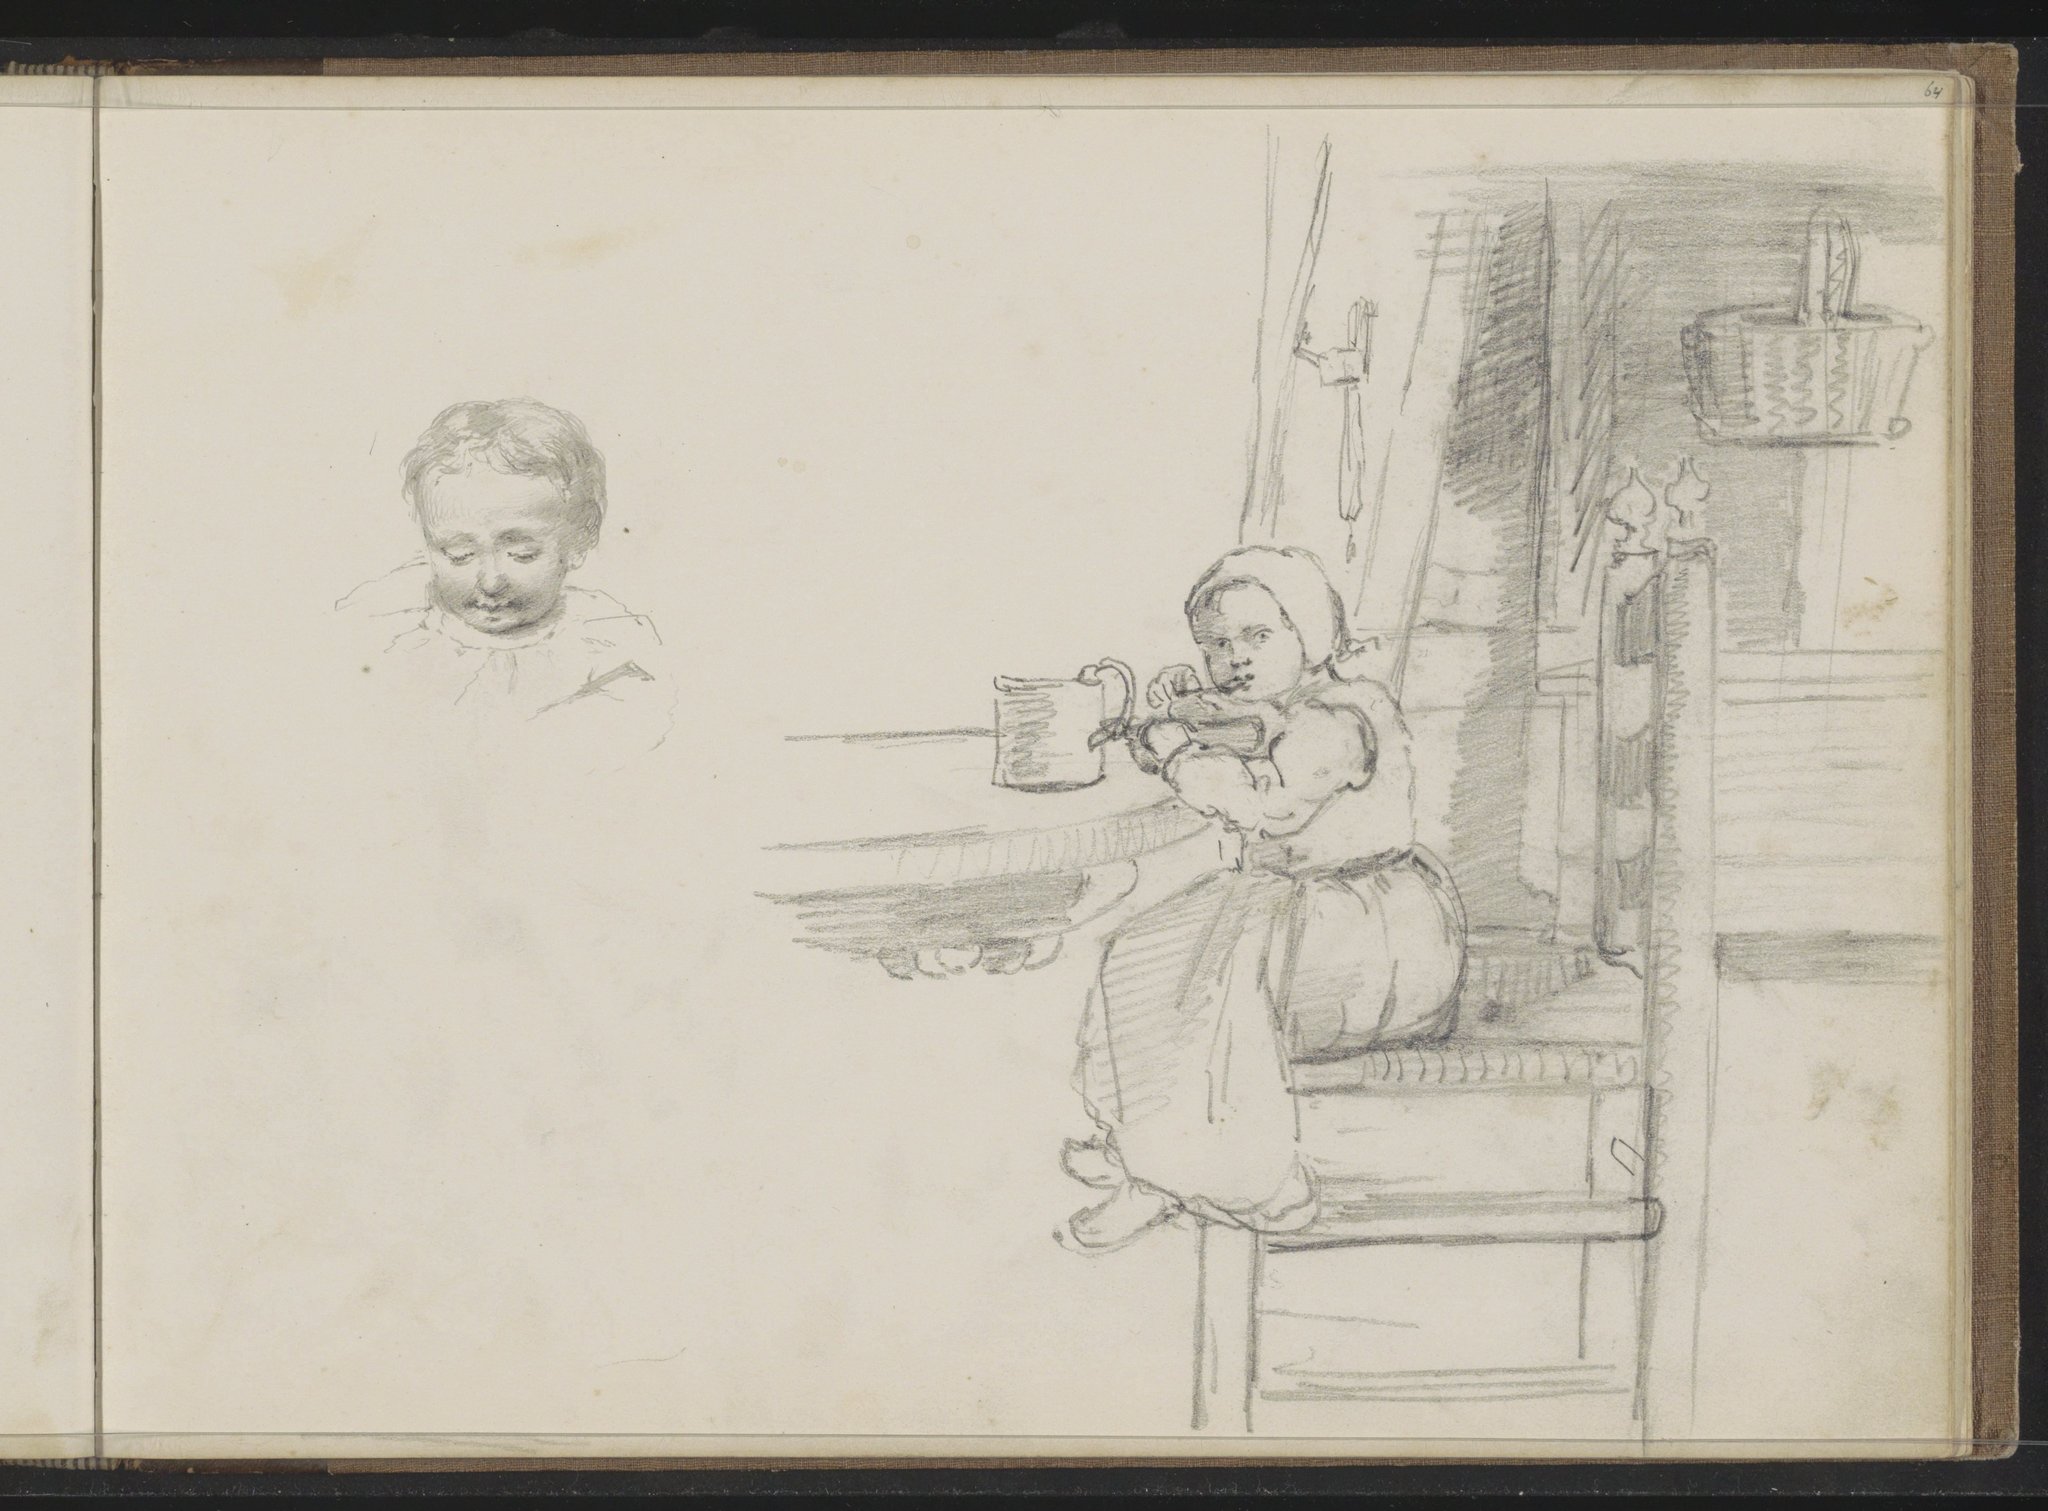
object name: sketchbook leaf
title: Boereninterieur met een etend meisje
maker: hendrik valkenburg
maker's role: draughtsman, painter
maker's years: 1826-1896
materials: paper, pencil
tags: cottage - aa - civic architecture: inside, girl (child between toddler and youth), eating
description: Tevens een studie van een kop van een kind. Blad 64 recto uit een schetsboek met 77 bladen.